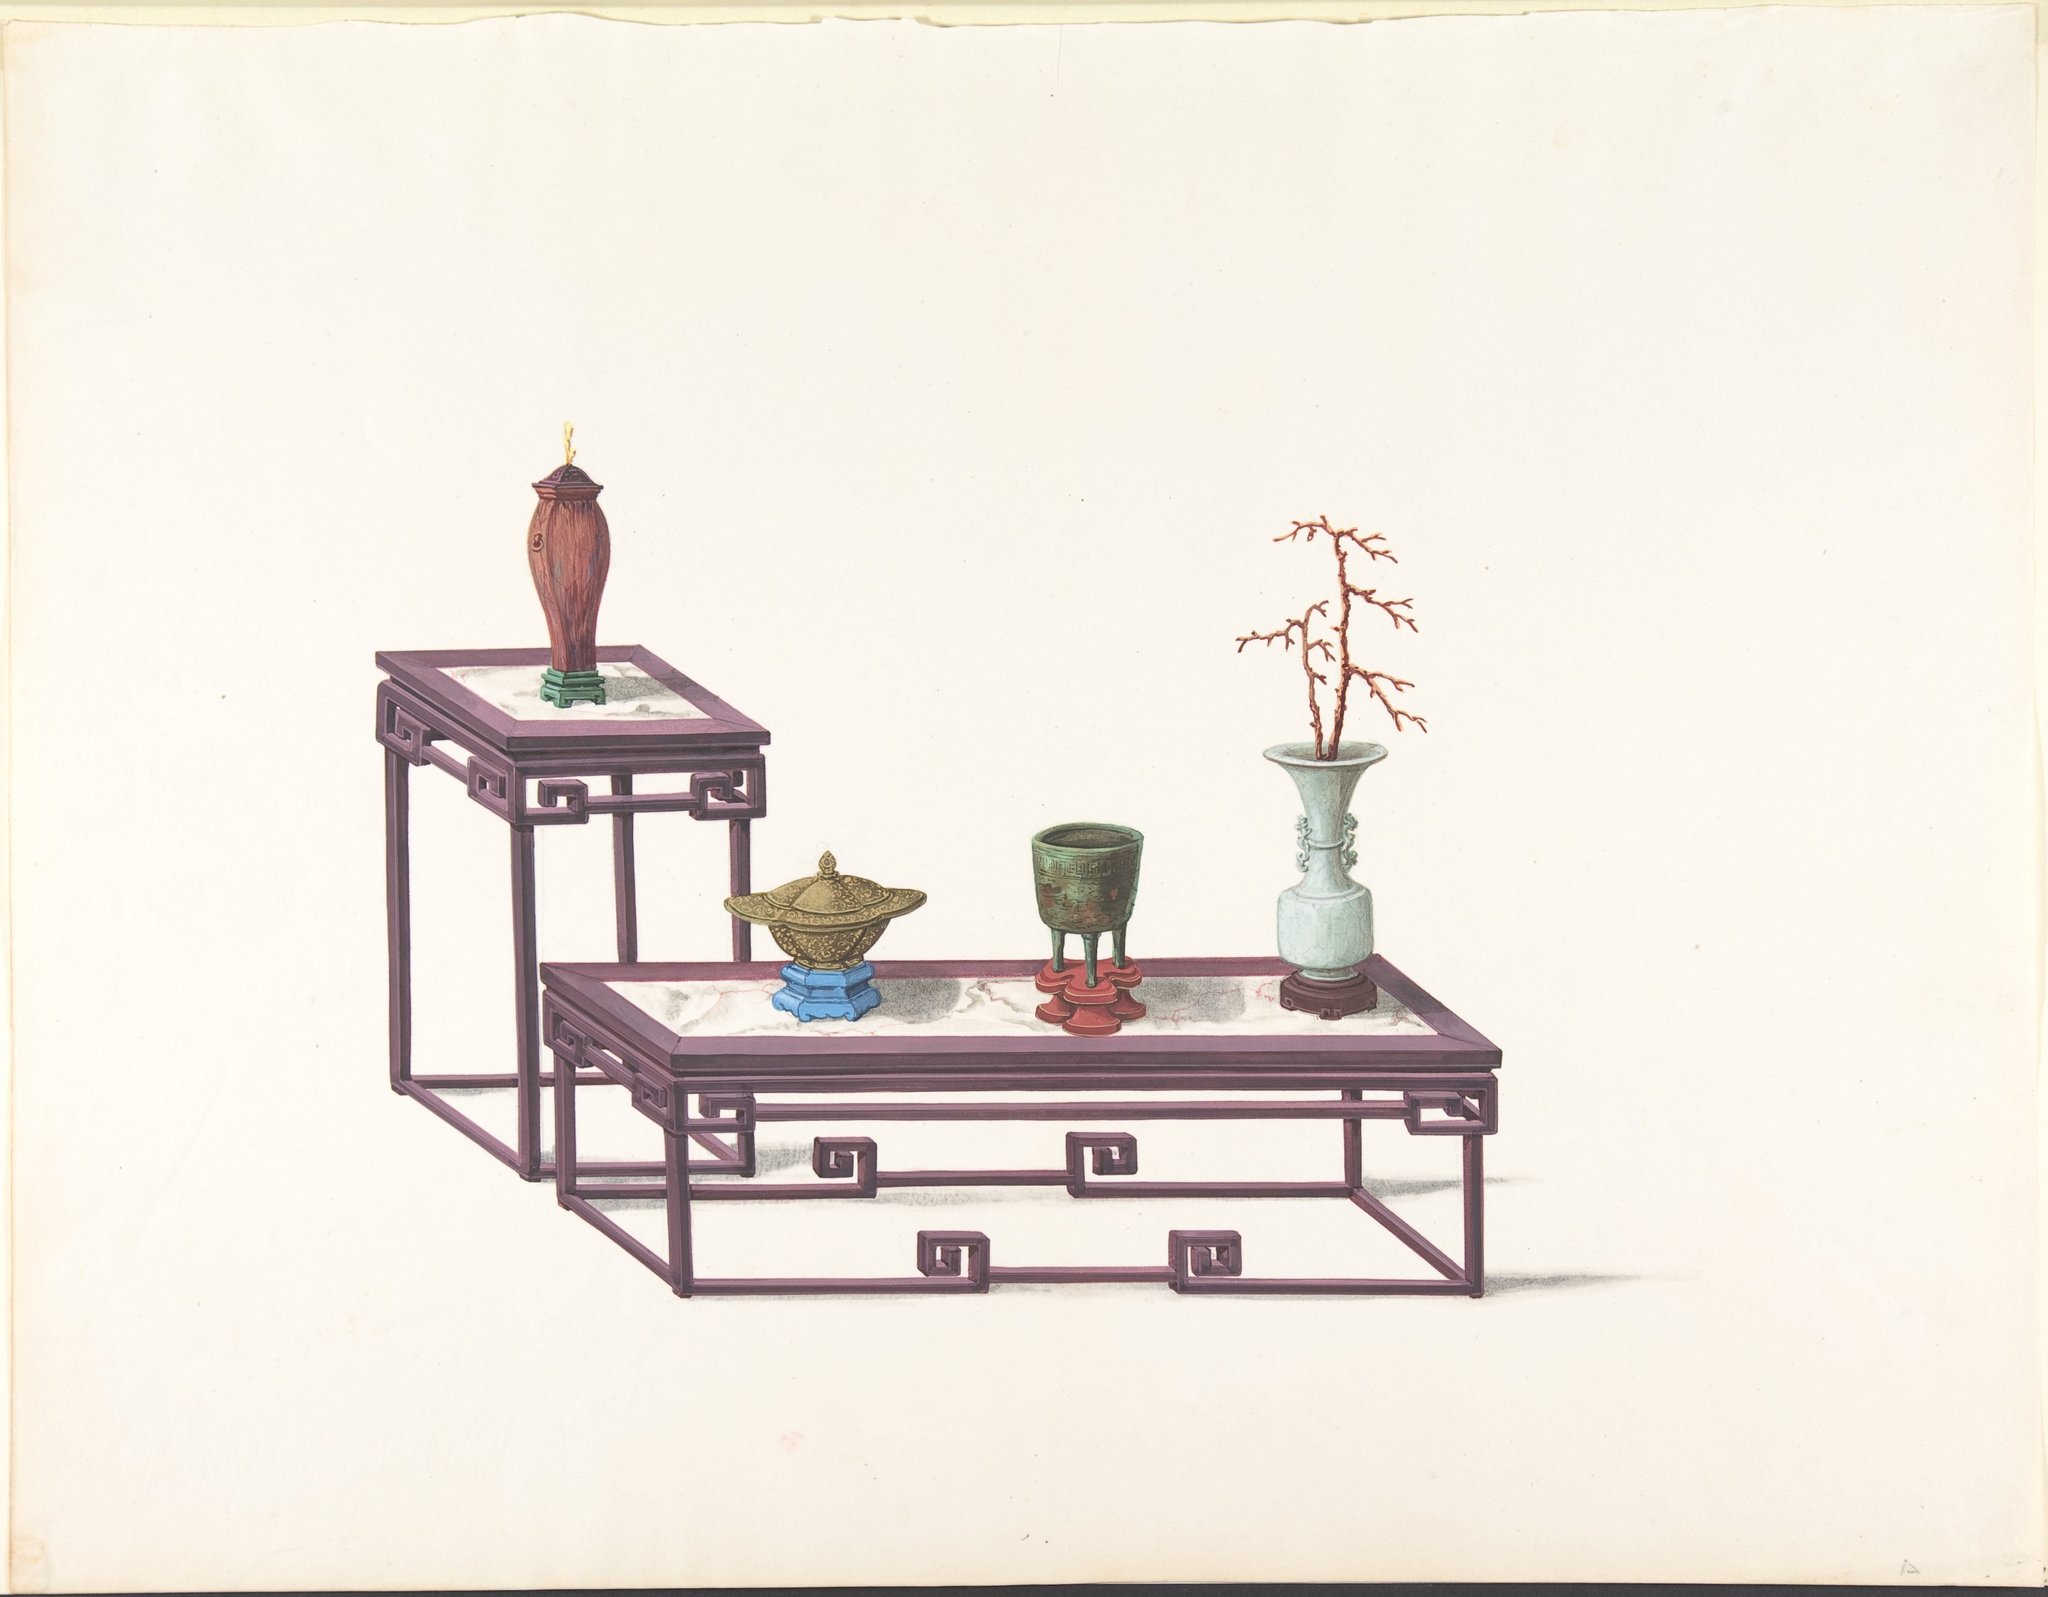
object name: drawing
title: Two Tables with a Purple Finish, One with a Red Vase, the Other with Three Vases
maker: anonymous, chinese, 19th century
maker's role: artist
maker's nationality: chinese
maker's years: 1800-1900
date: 1801-1900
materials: gouache, ink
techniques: pen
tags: tables,vases